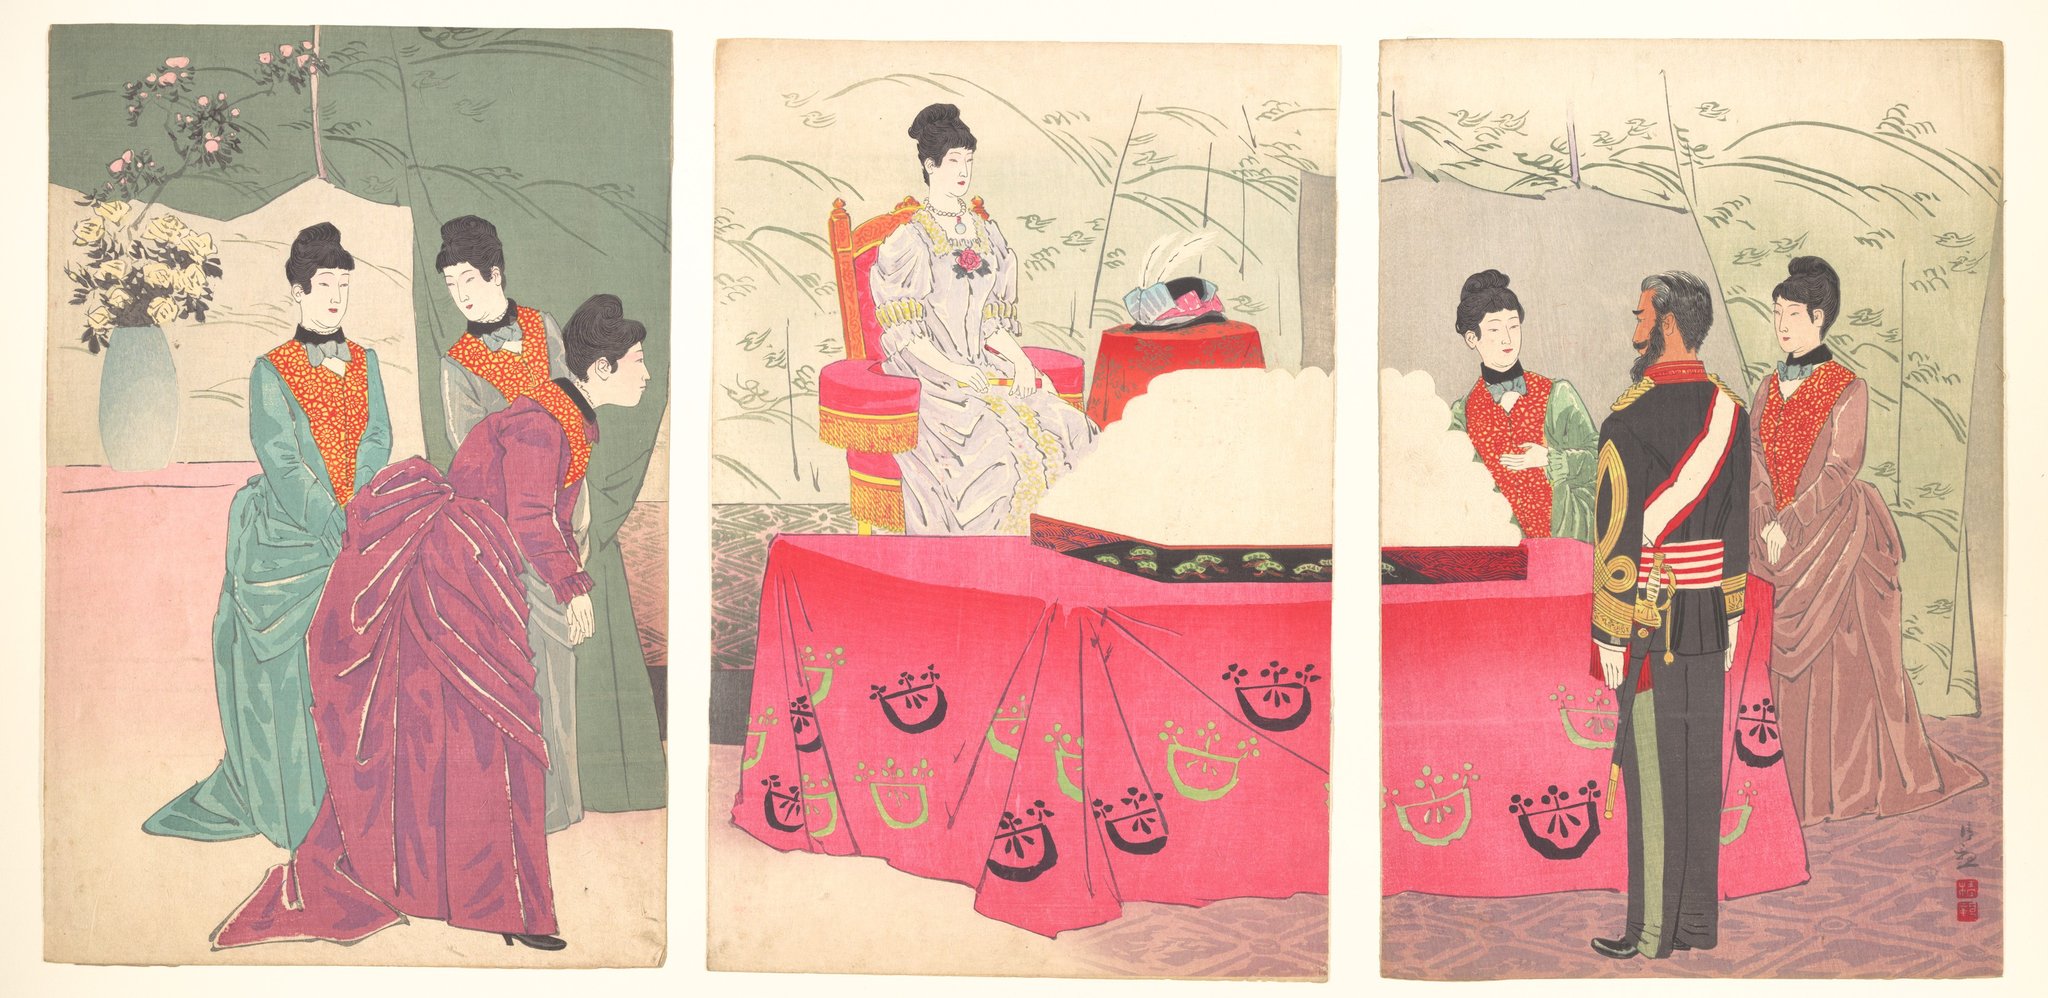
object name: print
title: Illustration of the Empress Visiting the General Staff Headquarters [to present a tray of bandages] (Sanbō honbu gyōkei no zu)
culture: japanese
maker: kobayashi kiyochika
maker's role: artist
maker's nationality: japanese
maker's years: 1847-1915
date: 1895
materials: ink, paper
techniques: woodblock print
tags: queens,men,women